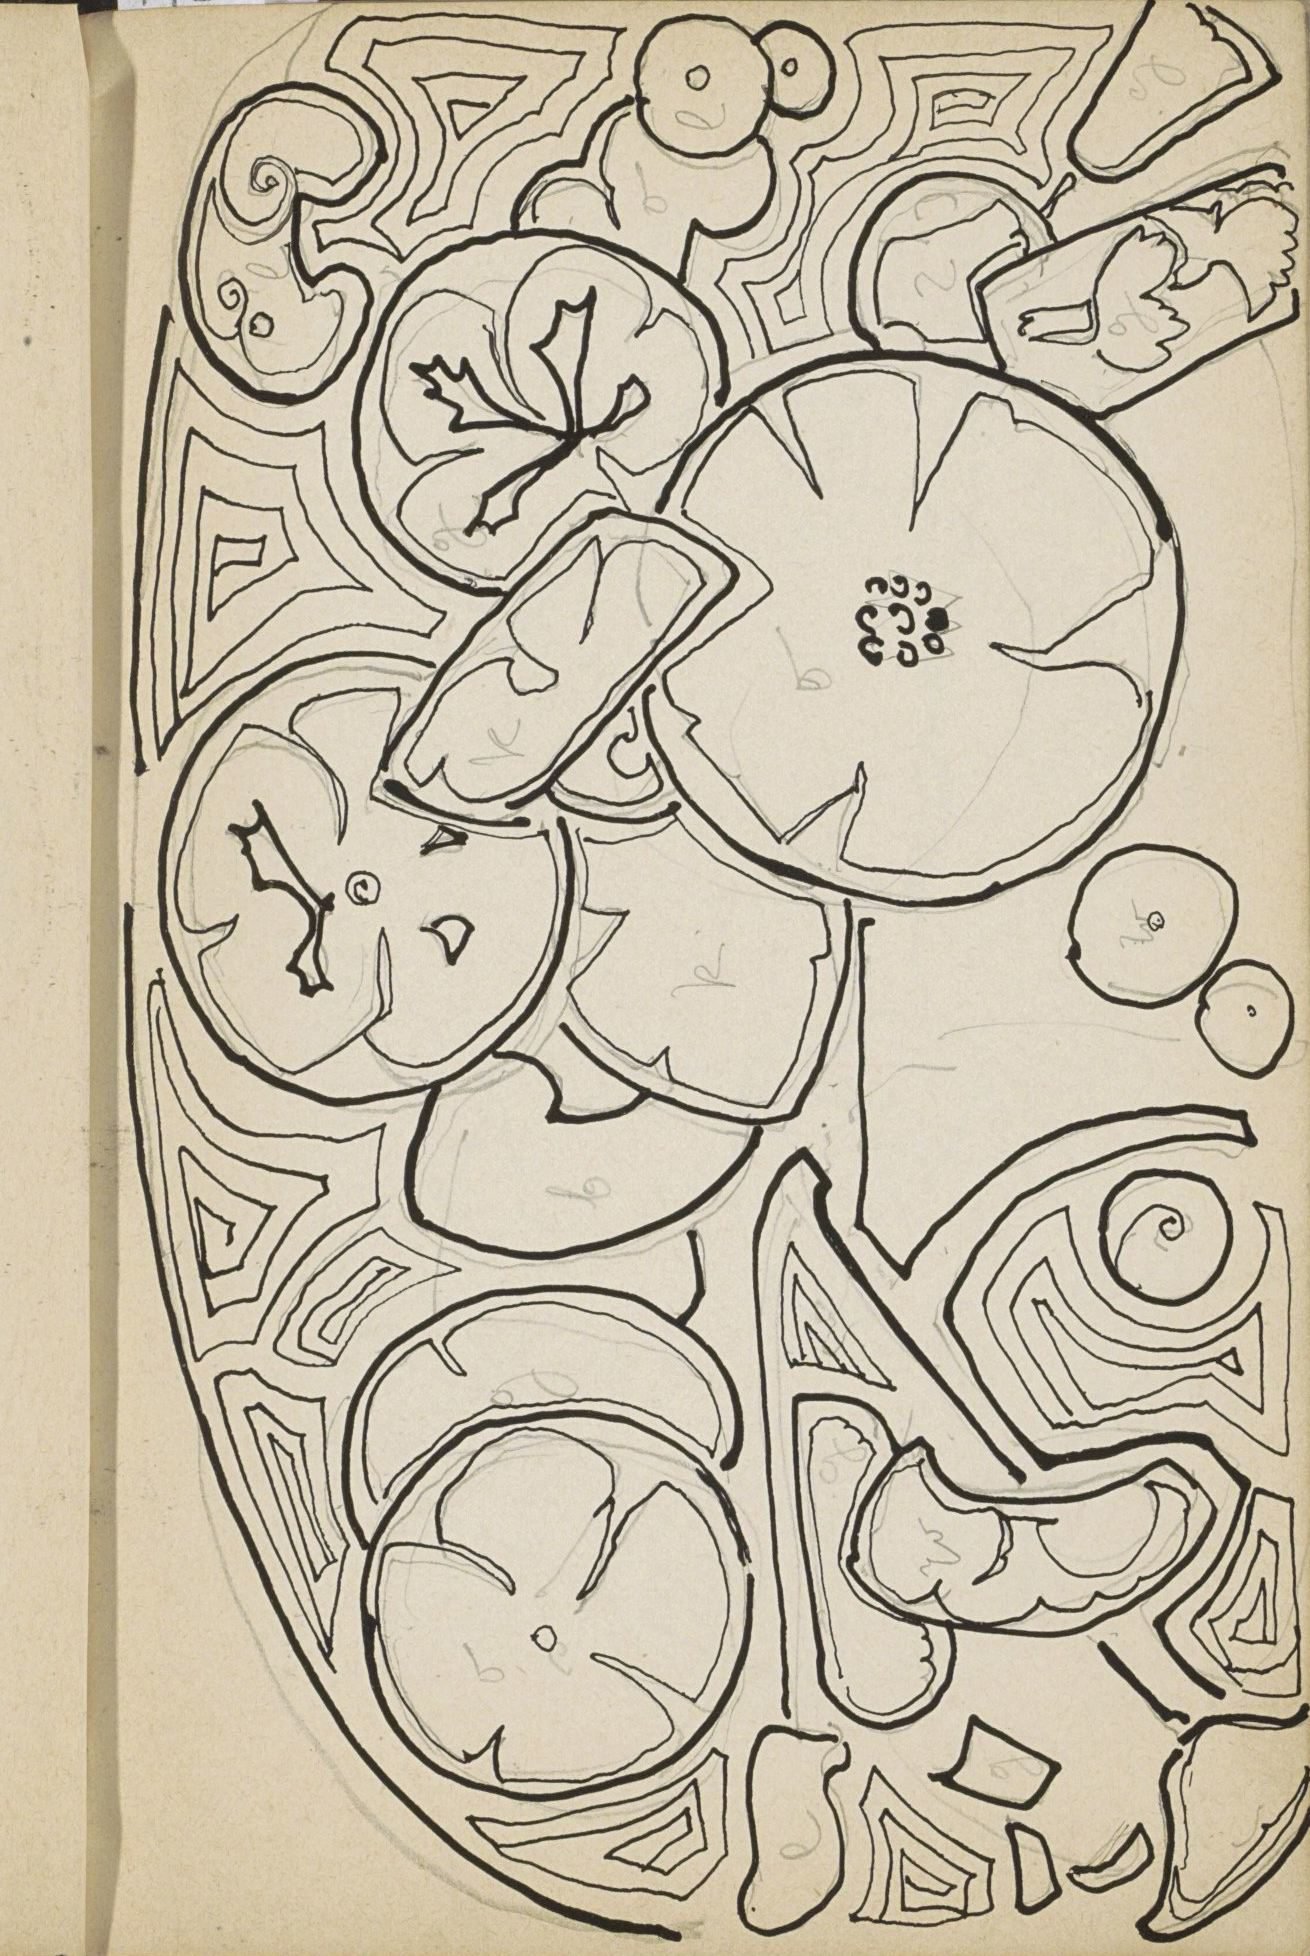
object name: sketchbook leaf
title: Ornament met bloemen en bladeren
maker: reijer stolk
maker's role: draughtsman, print maker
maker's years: 1896-1945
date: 1908-1919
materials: ink, paper, pencil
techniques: pen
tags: ornament derived from plant forms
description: Blad 4 recto uit een schetsboek met 33 bladen.